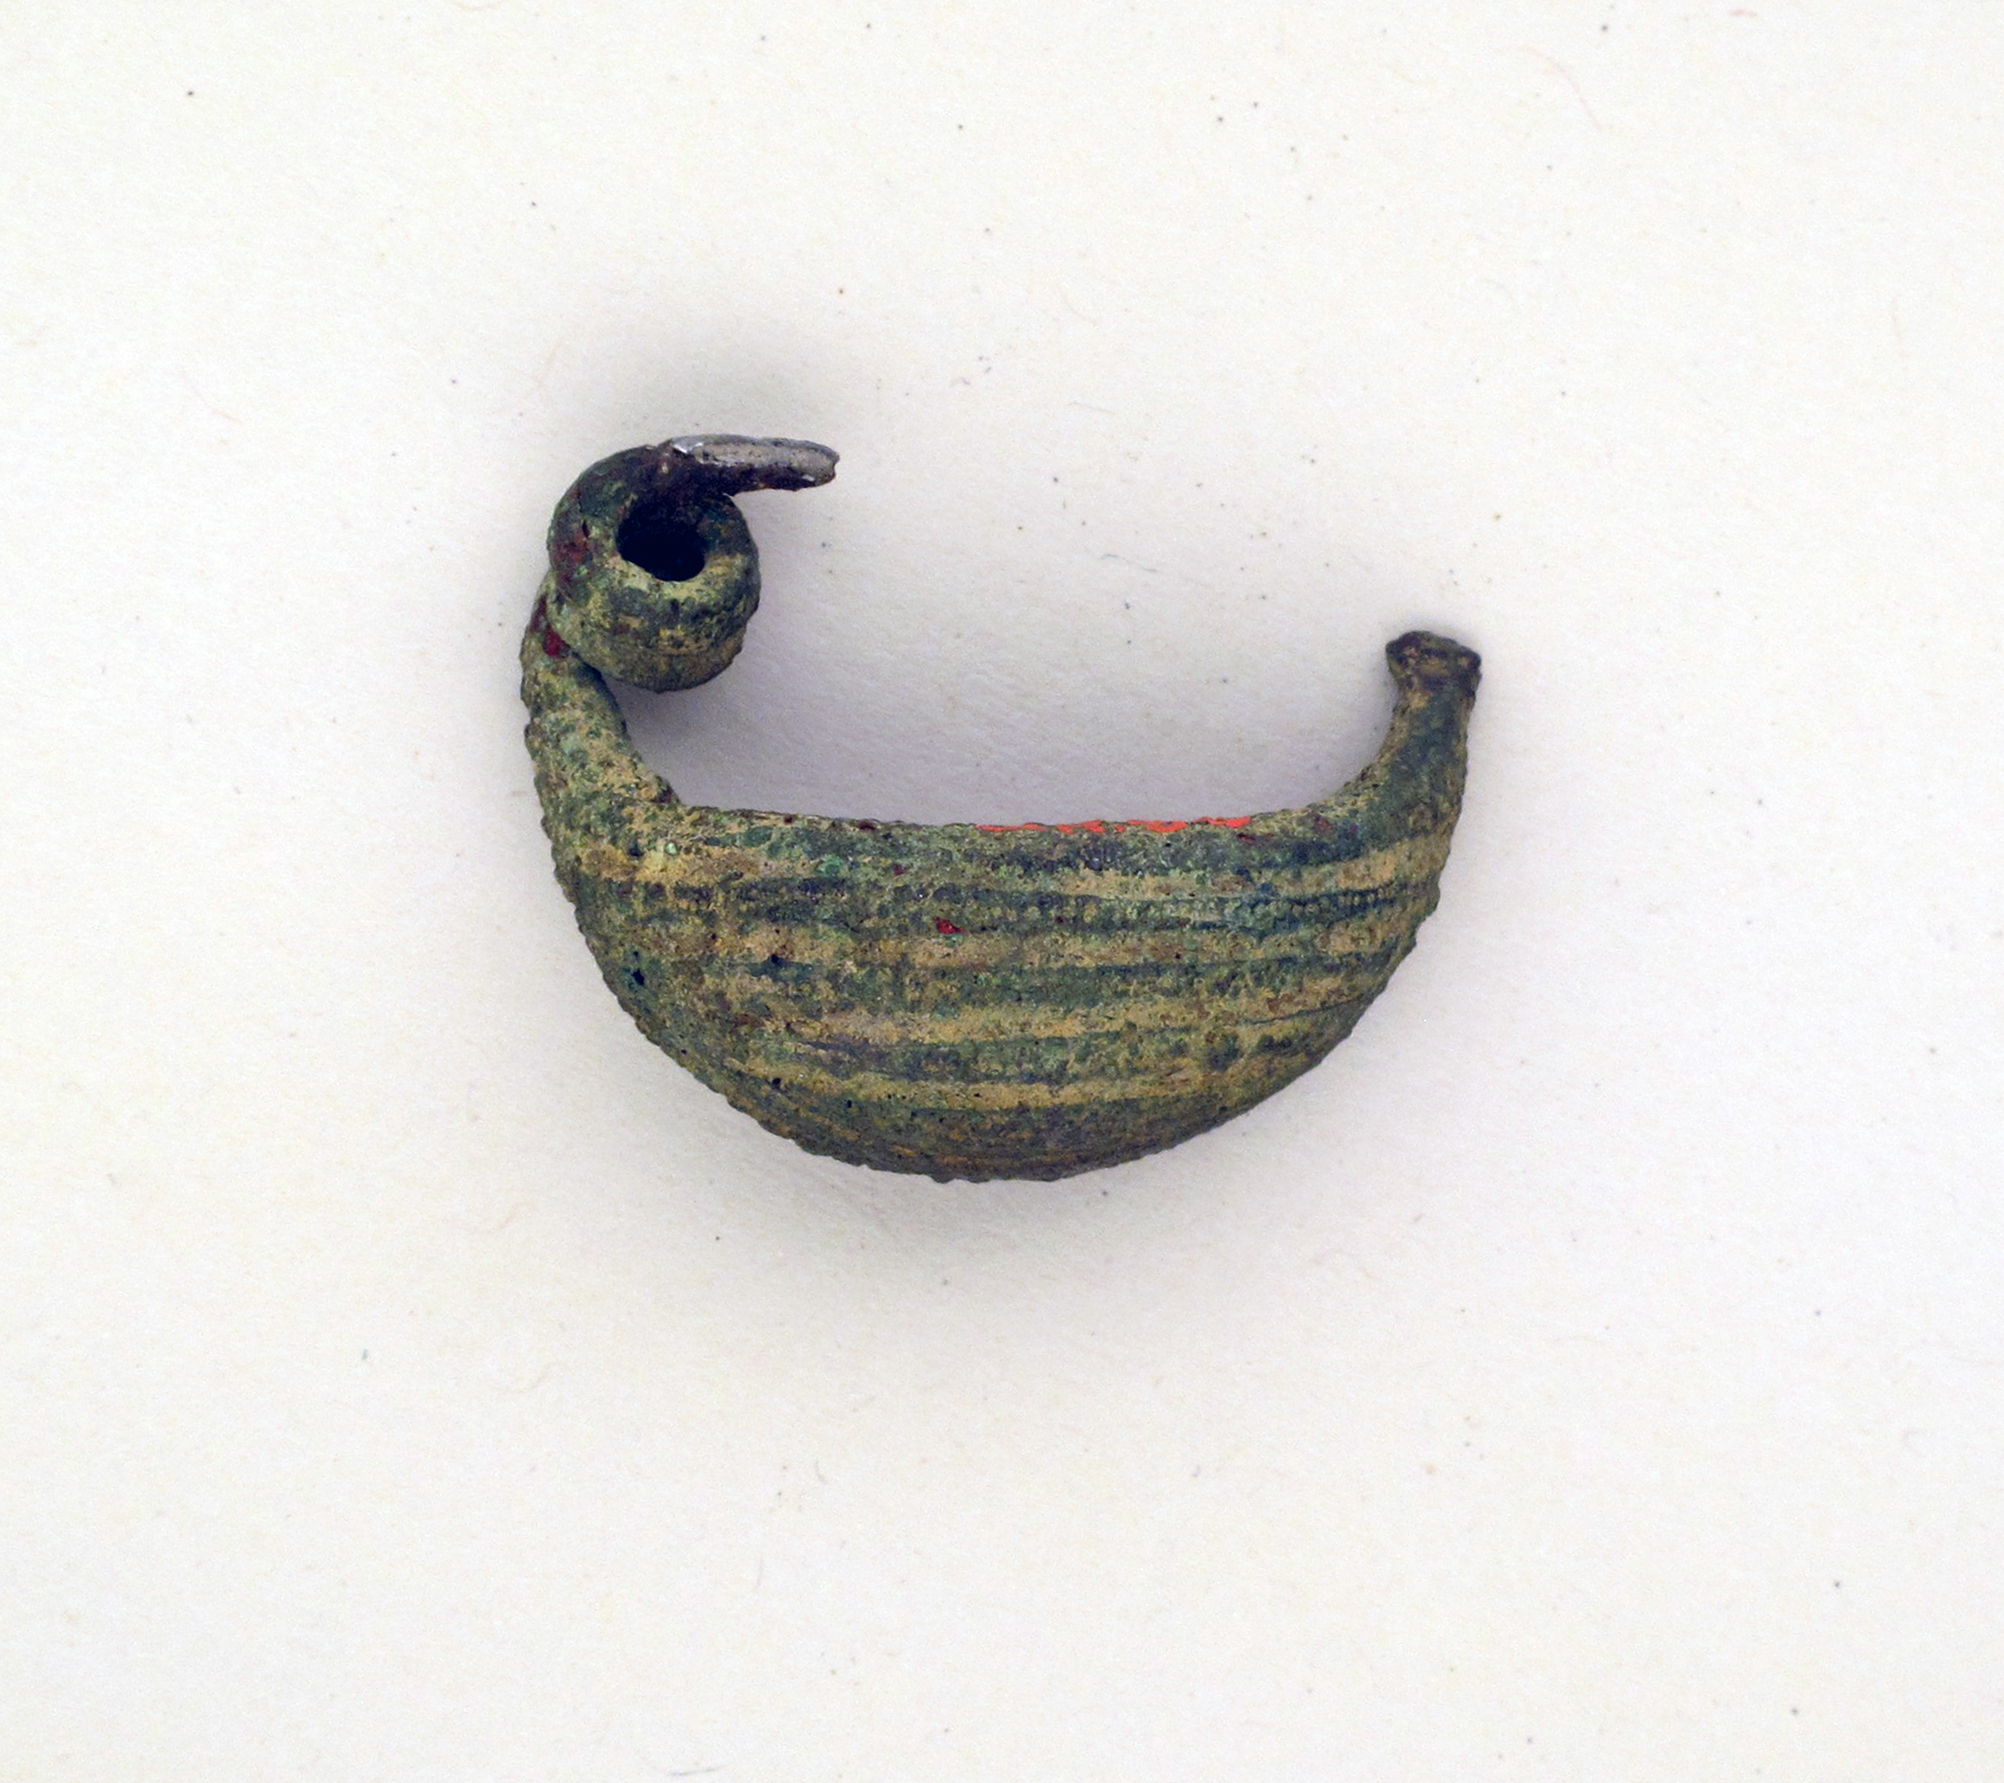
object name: fibula, boat shaped type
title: Fibula, boat-shaped type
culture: italic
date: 800-501 BCE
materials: bronze